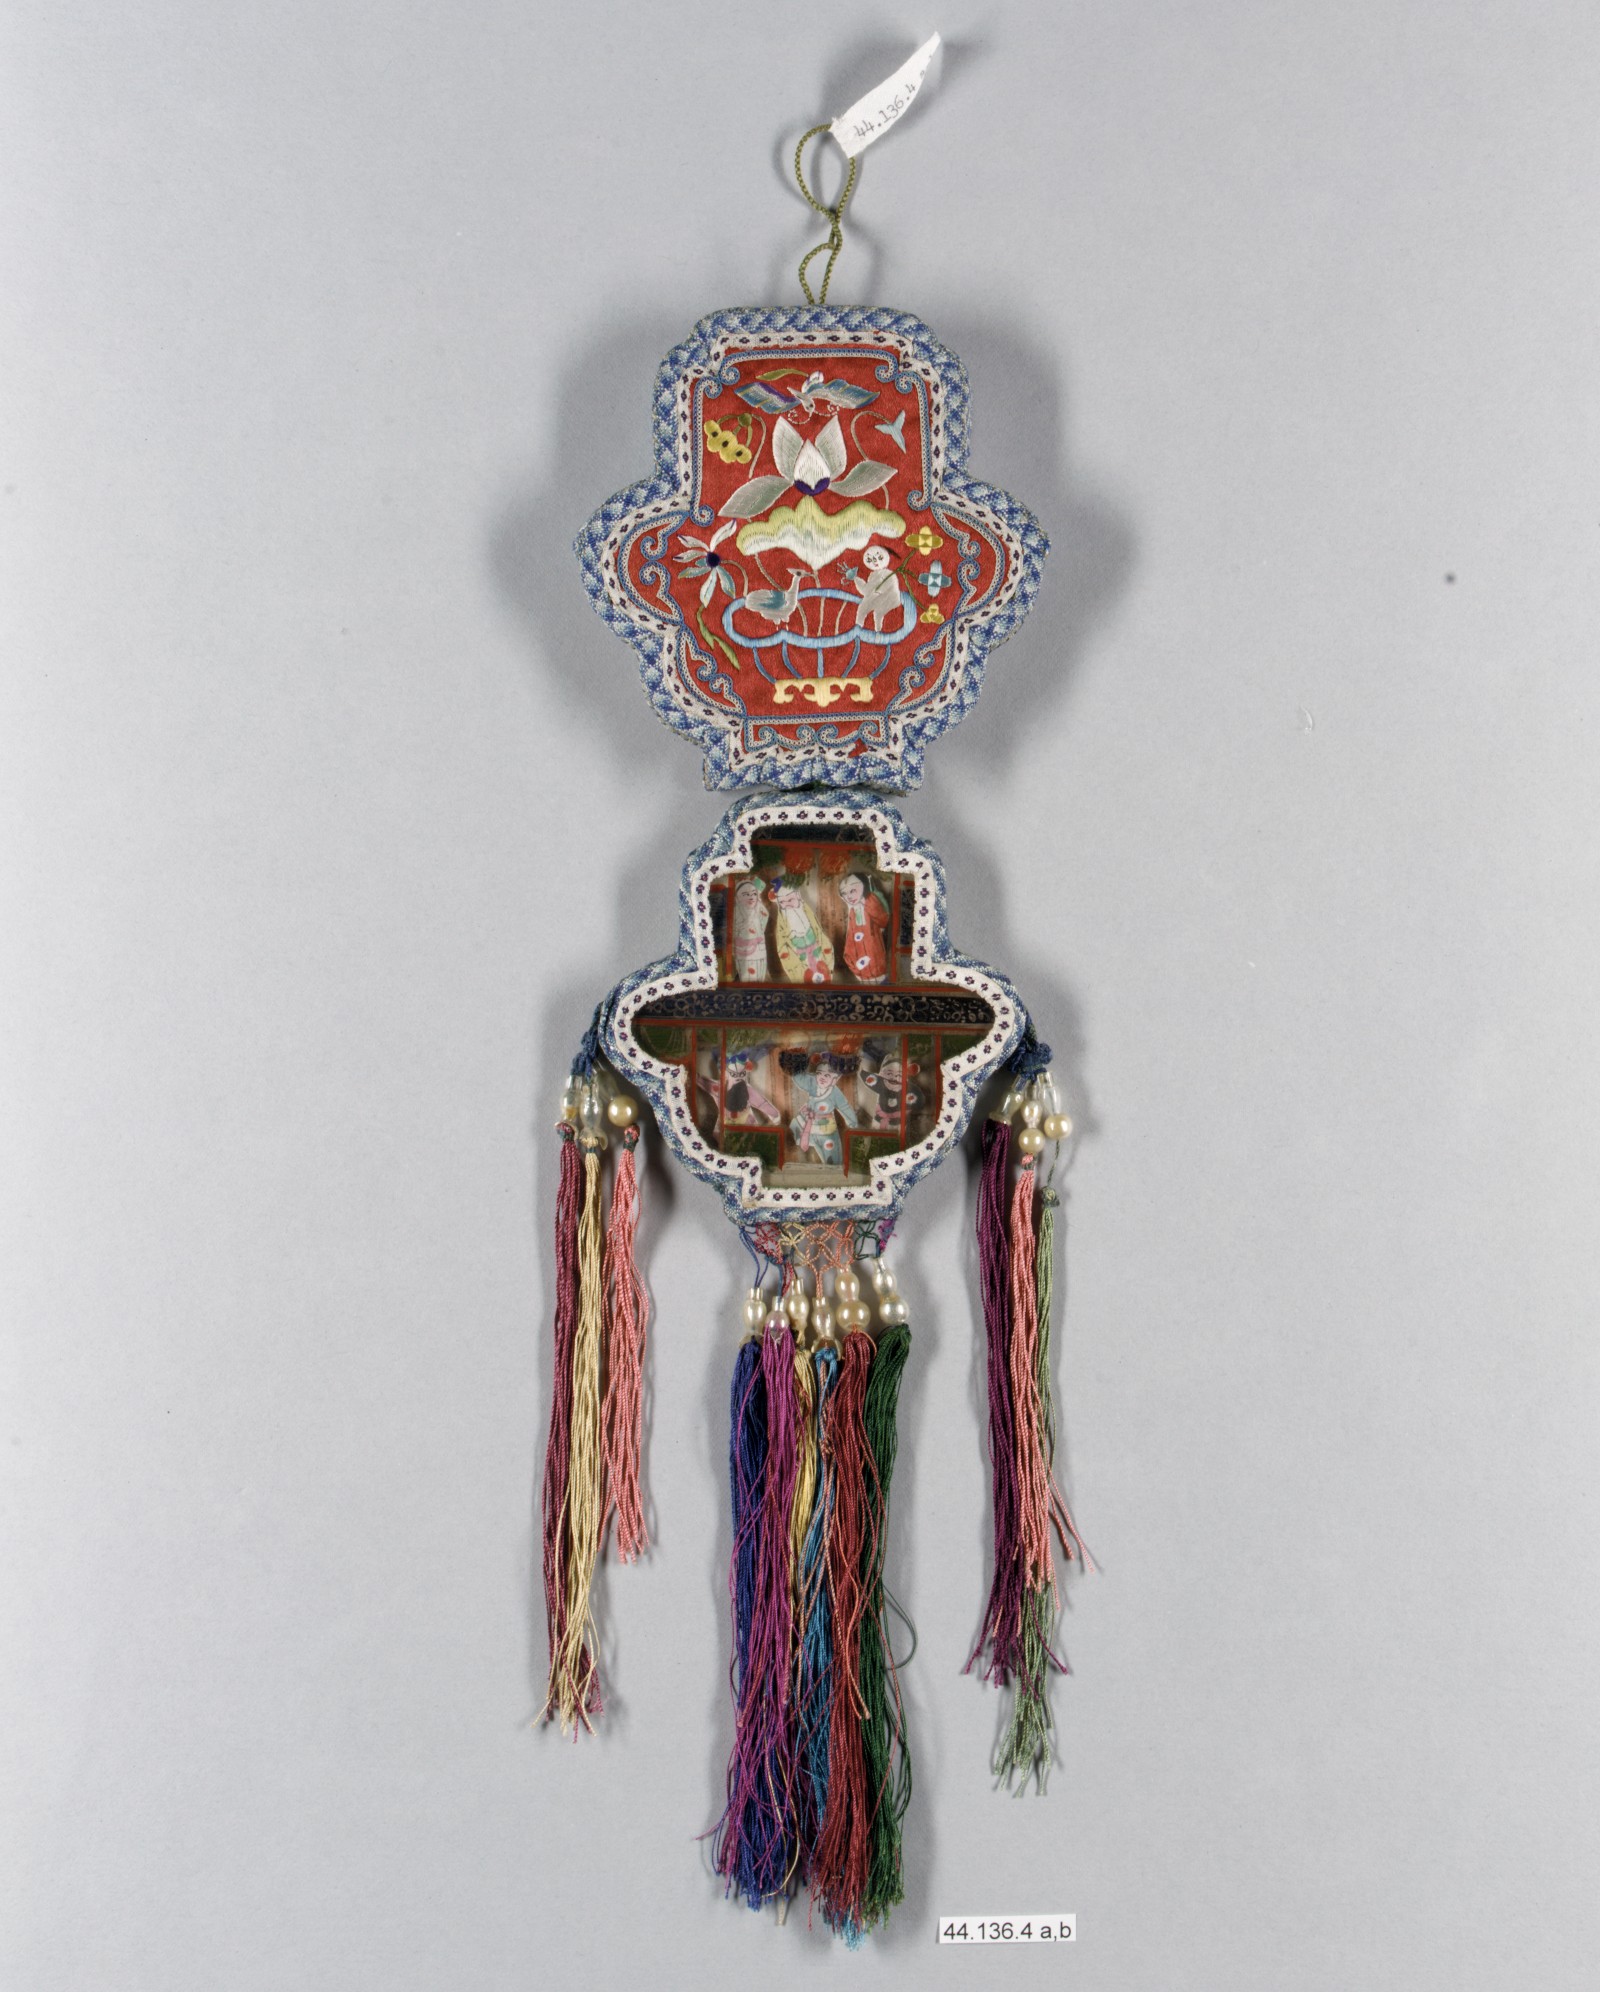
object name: mirror case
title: Mirror and Case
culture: chinese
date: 1801-1900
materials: glass, paper, silk